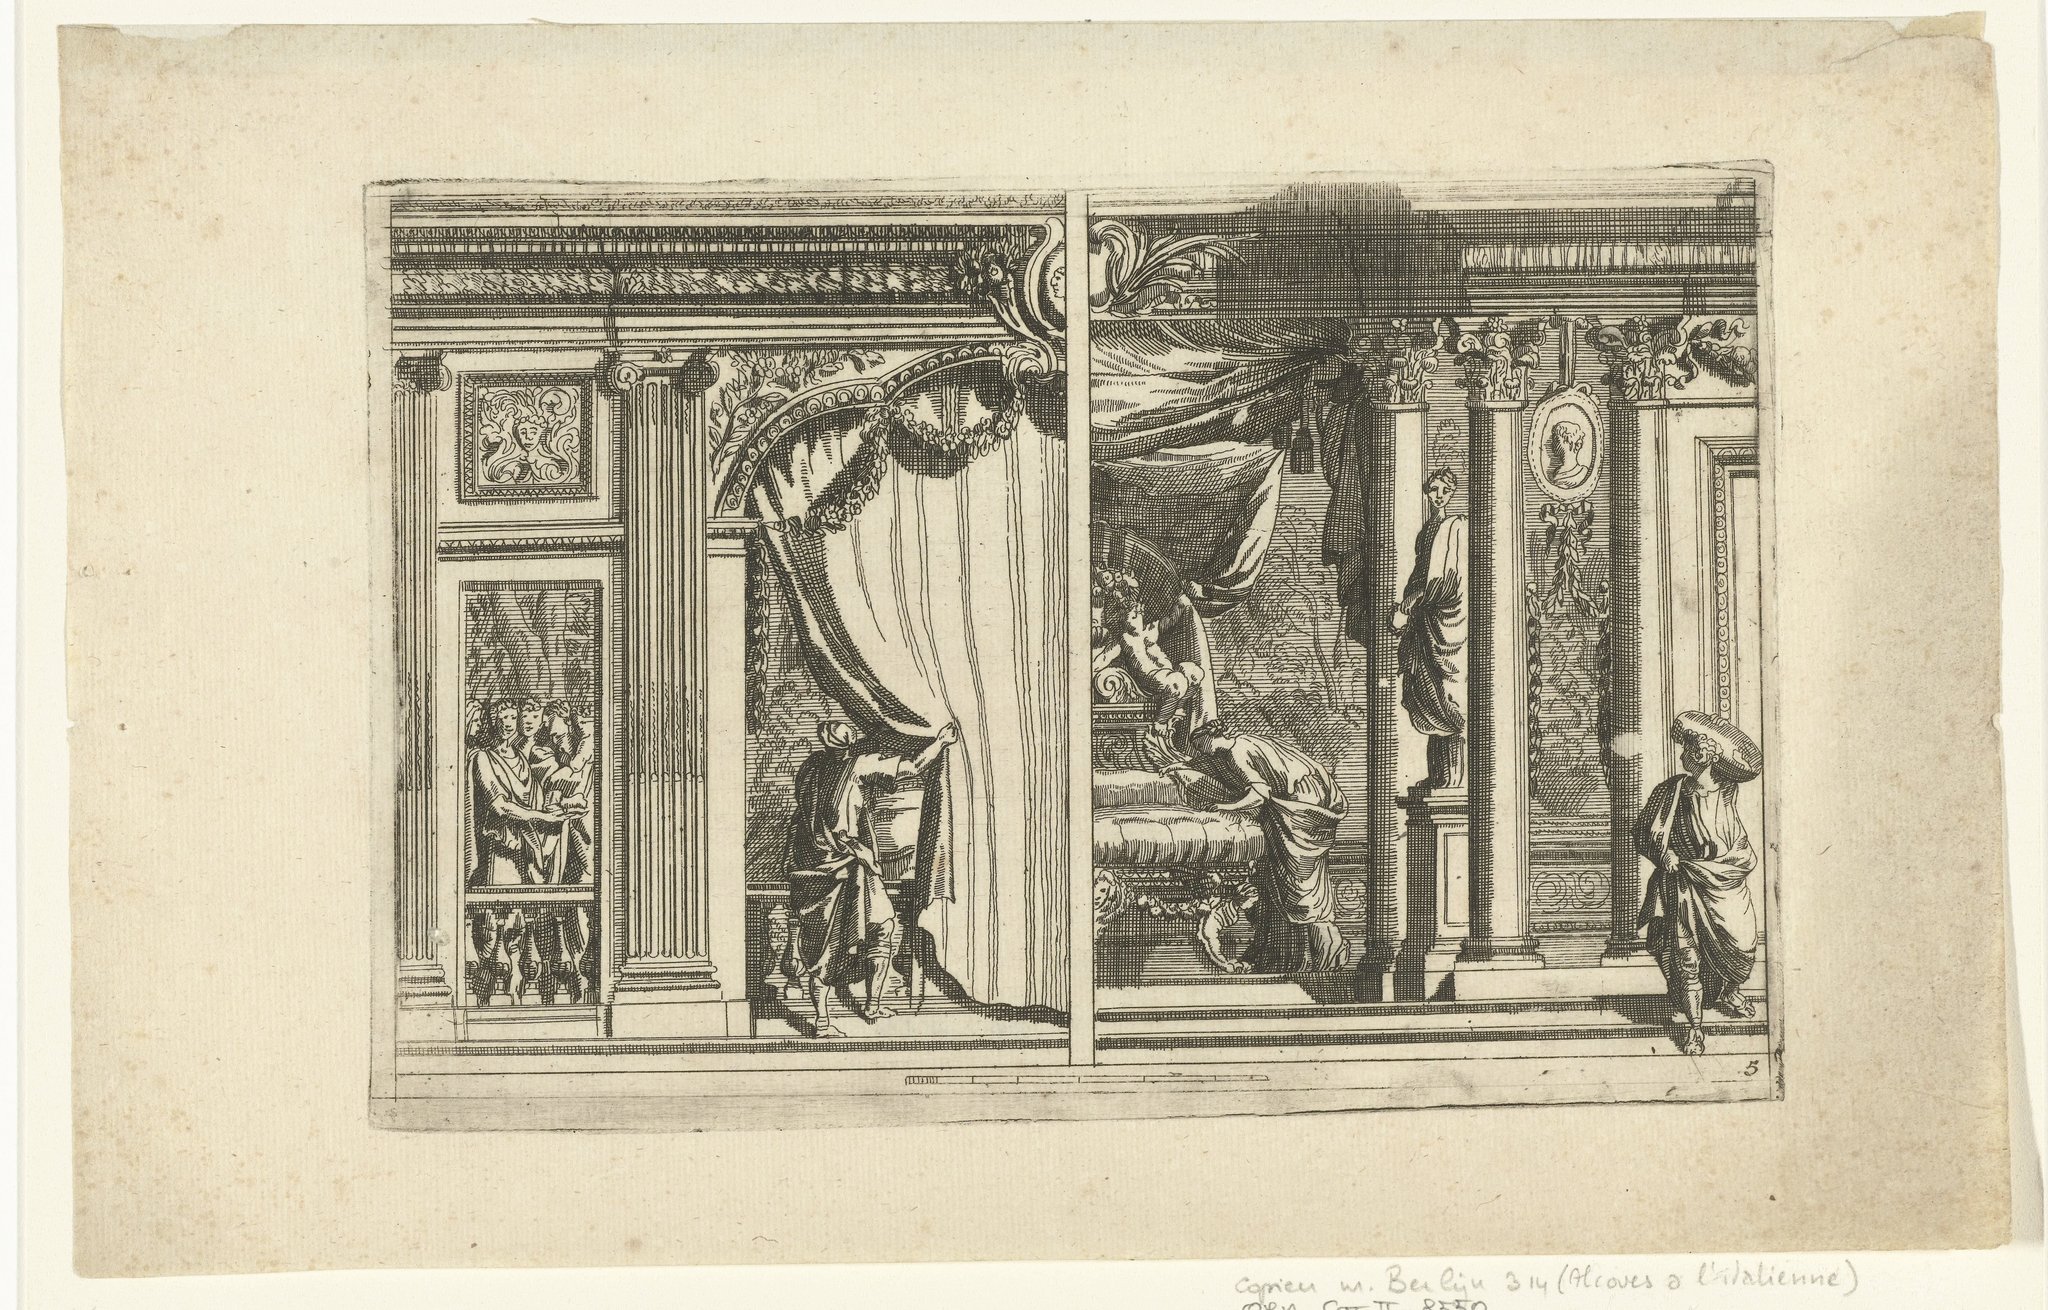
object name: print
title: Alkoven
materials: paper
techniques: etching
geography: france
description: Links houdt een bediende het gordijn van de alkoof opzij.